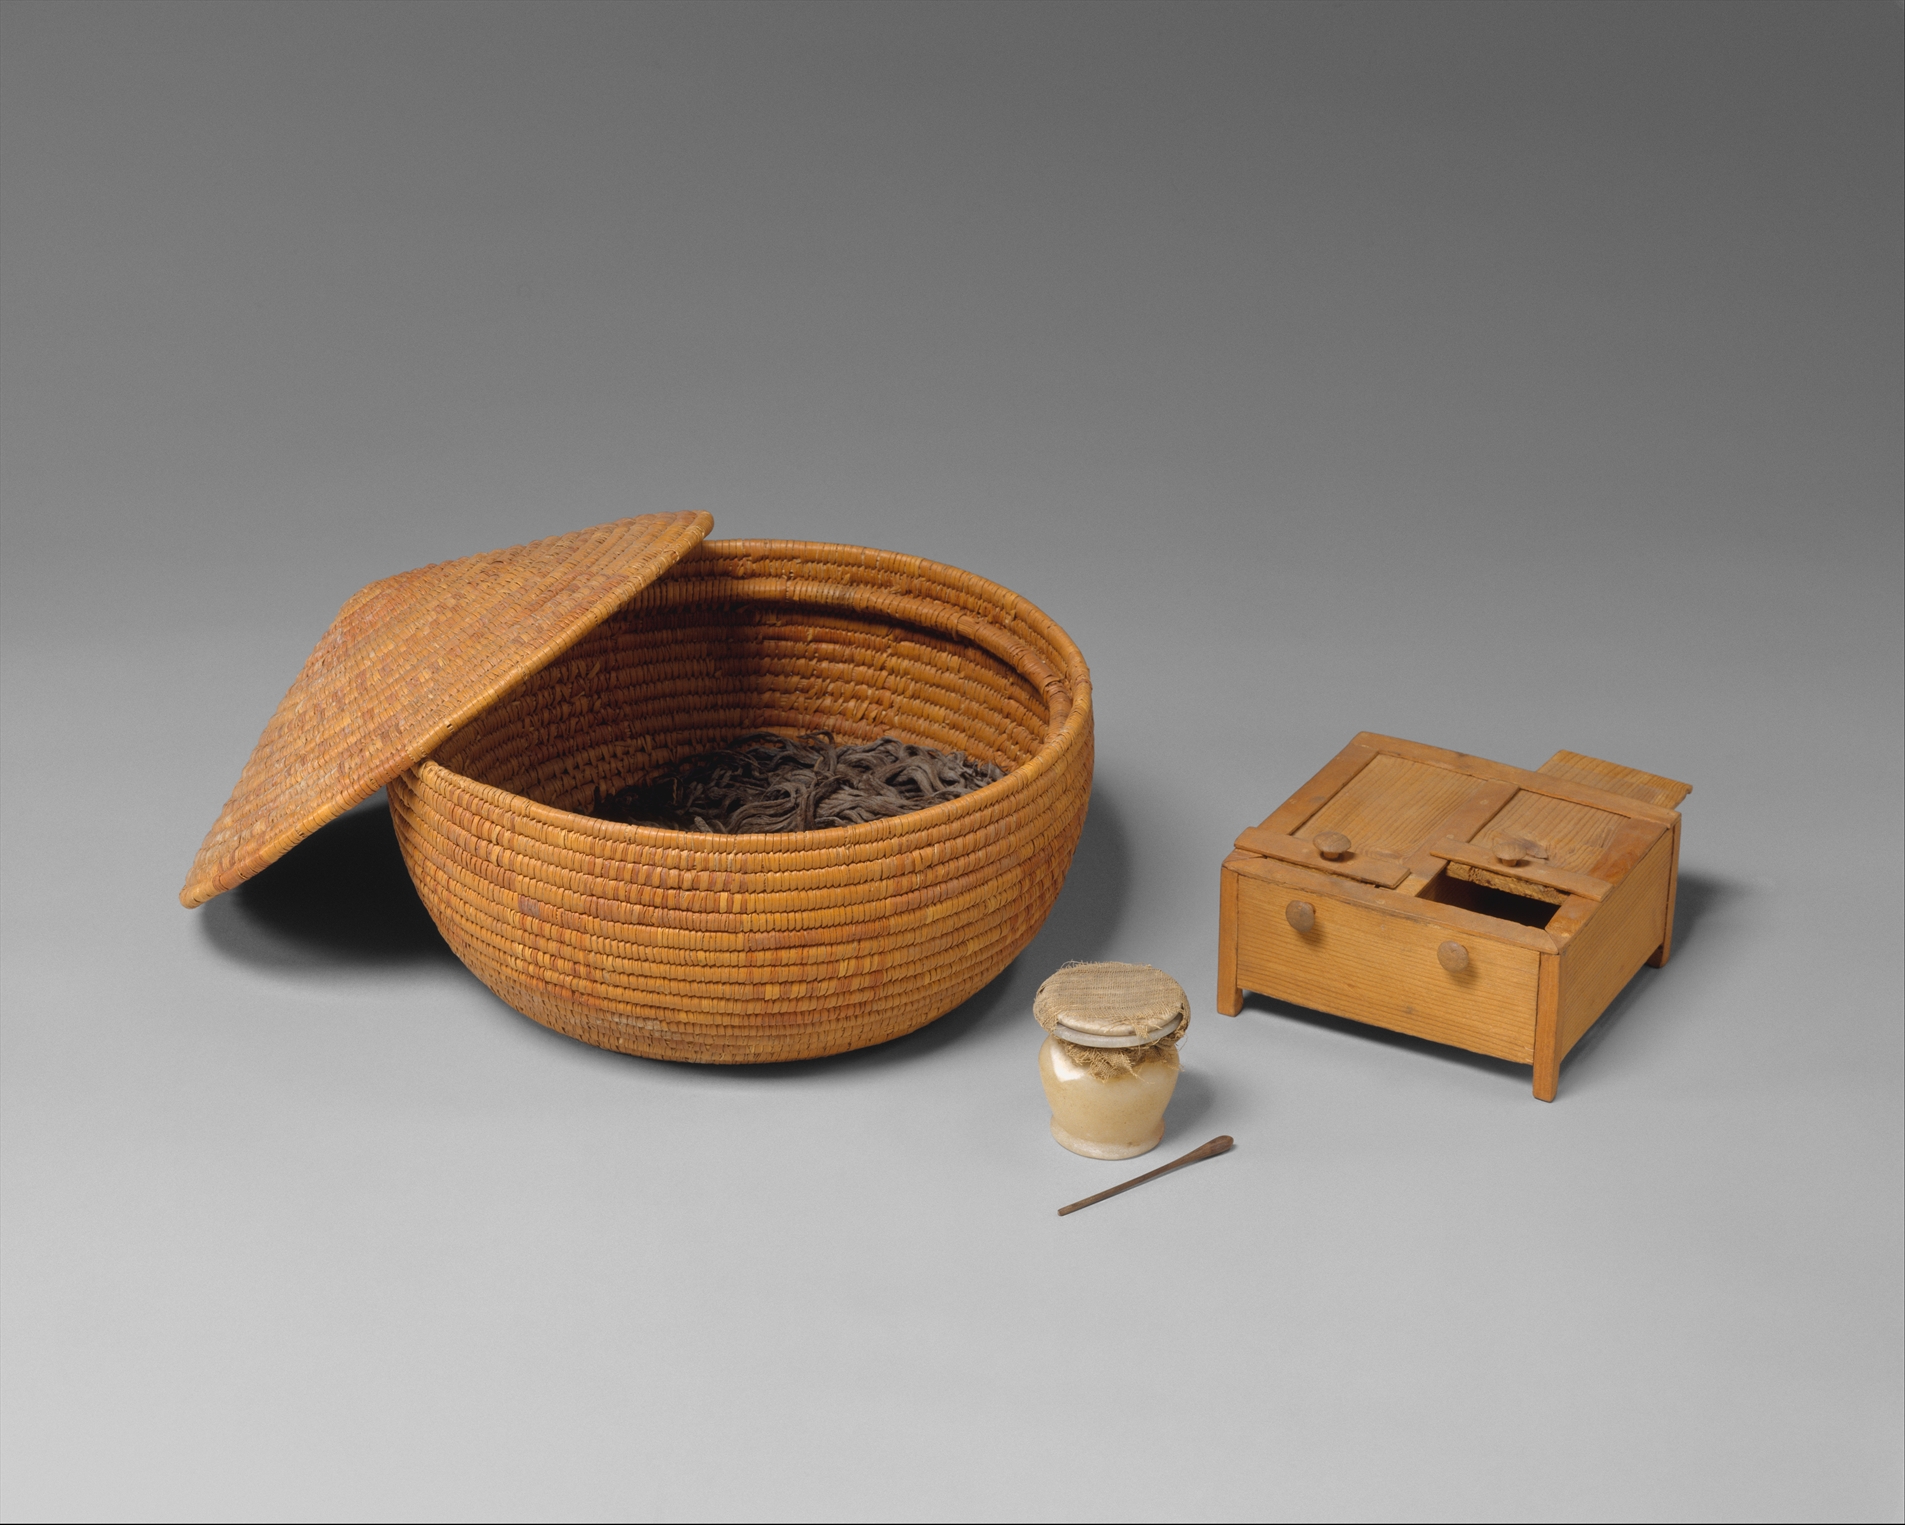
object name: basket, hemisphere, conical lid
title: Basket and toilet articles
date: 1479-1458 BCE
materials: wood, cord, linen, stone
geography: egypt